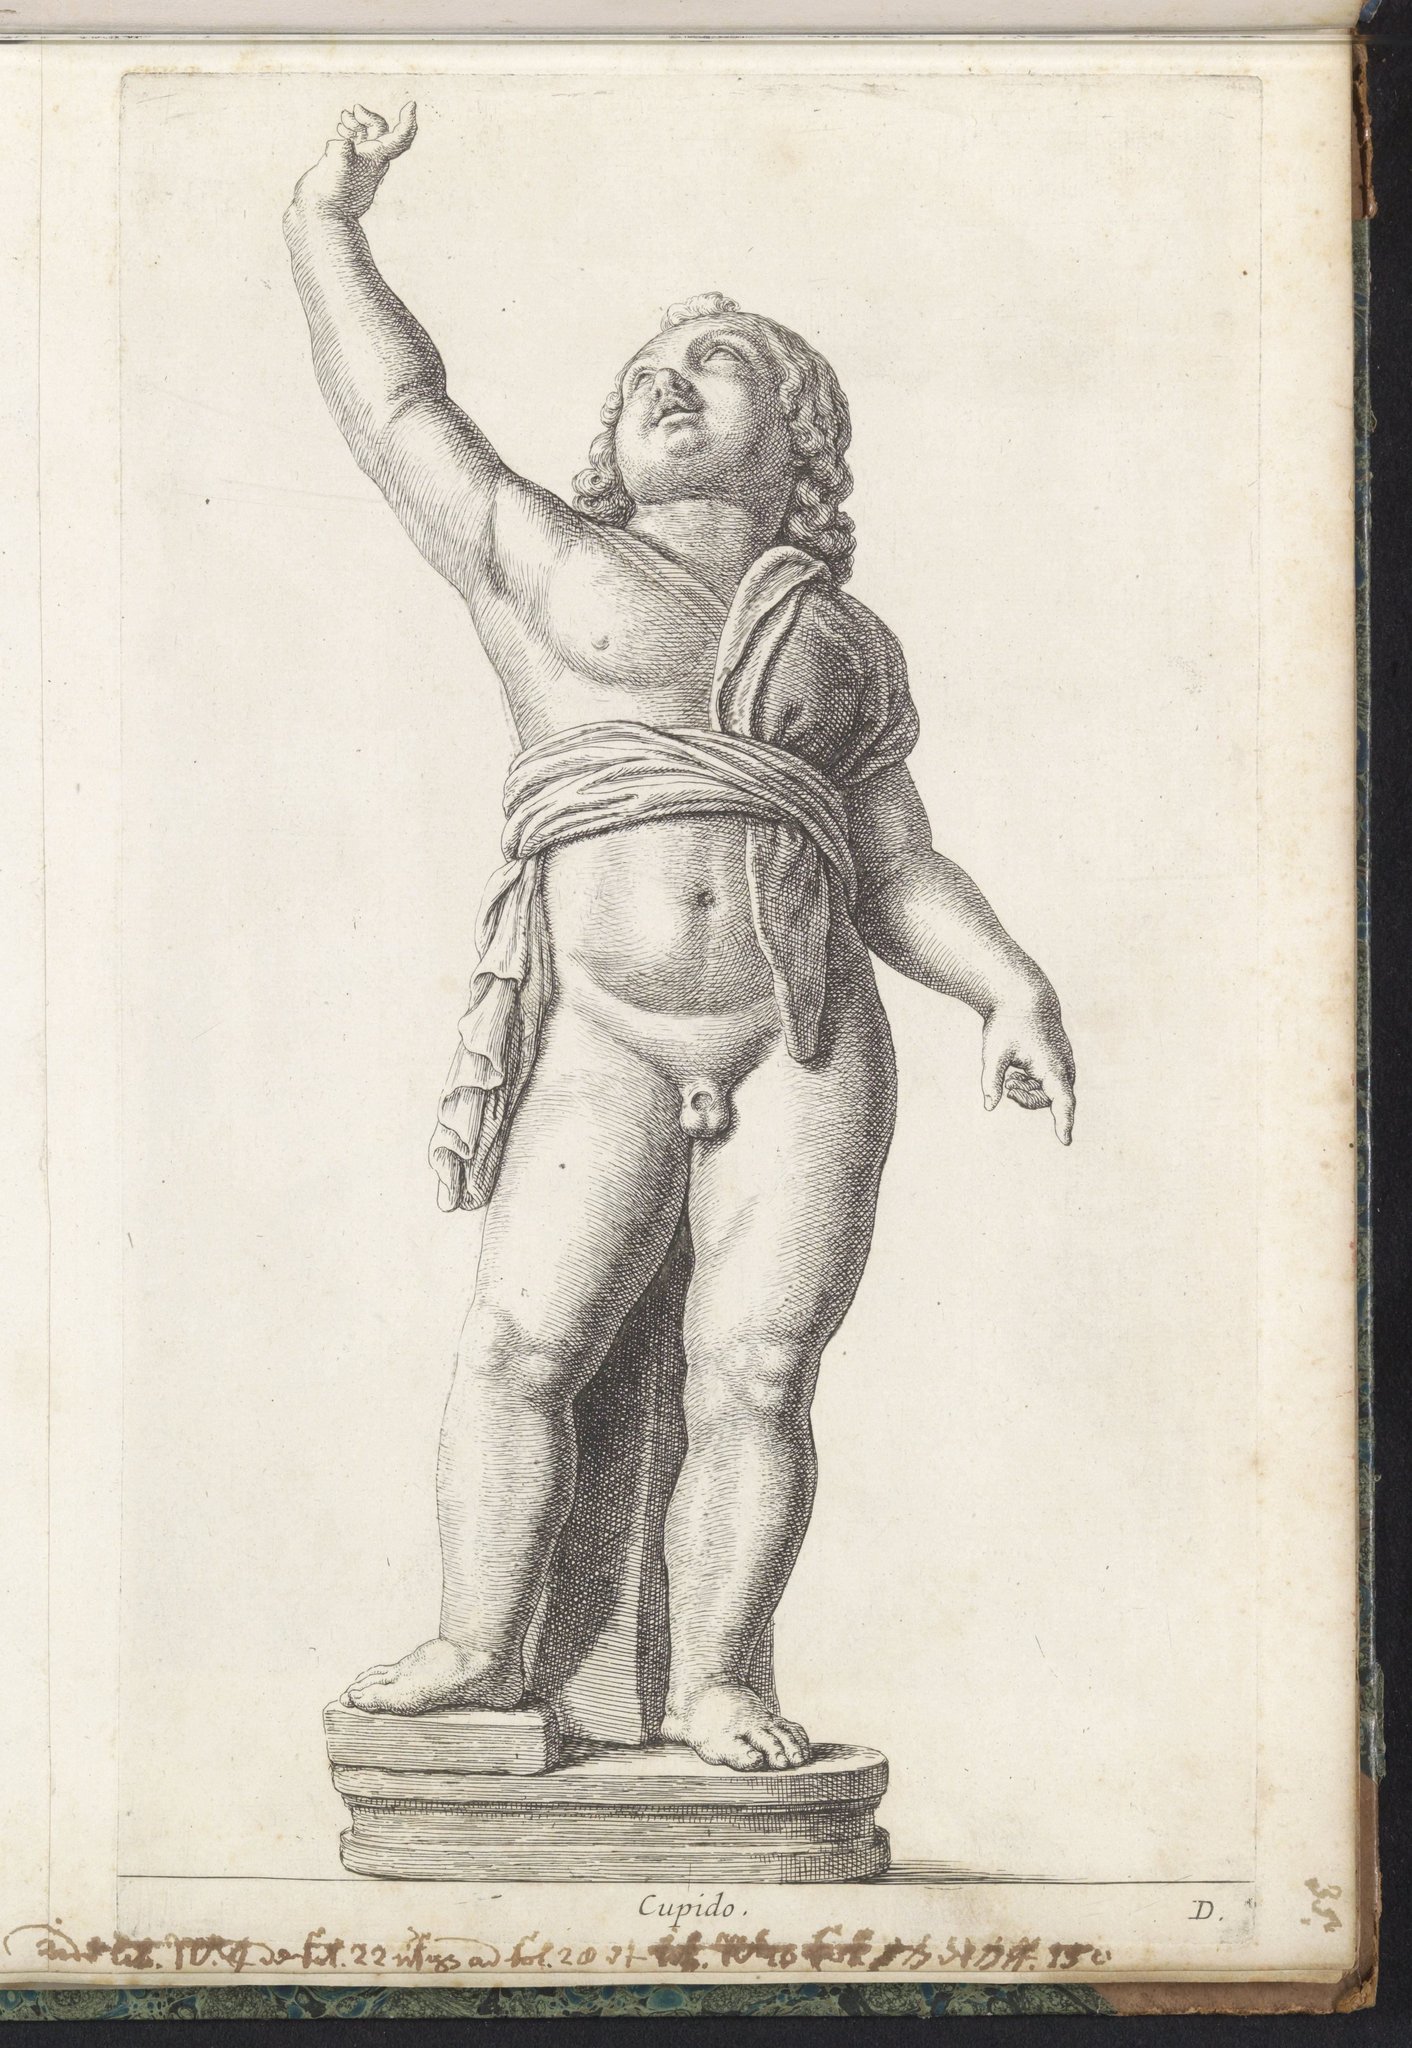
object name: album leaf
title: Sculptuur van Amor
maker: hubert quellinus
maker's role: print maker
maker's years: 1619-1687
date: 1646-1670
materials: paper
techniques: engraving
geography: antwerp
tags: piece of sculpture, reproduction of a piece of sculpture, (story of) cupid, amor (eros)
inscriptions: number: ‘35’, inscription: ‘Vide lib. No. 4 ... fol. 22 ... ad fol. 283 et ....’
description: Klassieke sculptuur van een jongen met krulhaar en een doek om zijn middel gebonden. Hij kijkt omhoog en heeft zijn rechterhand in de lucht. Rechtsonder: D. De prent maakt deel uit van een album met een serie prenten naar de sculpturen in de verzameling van Gerard Reynst.